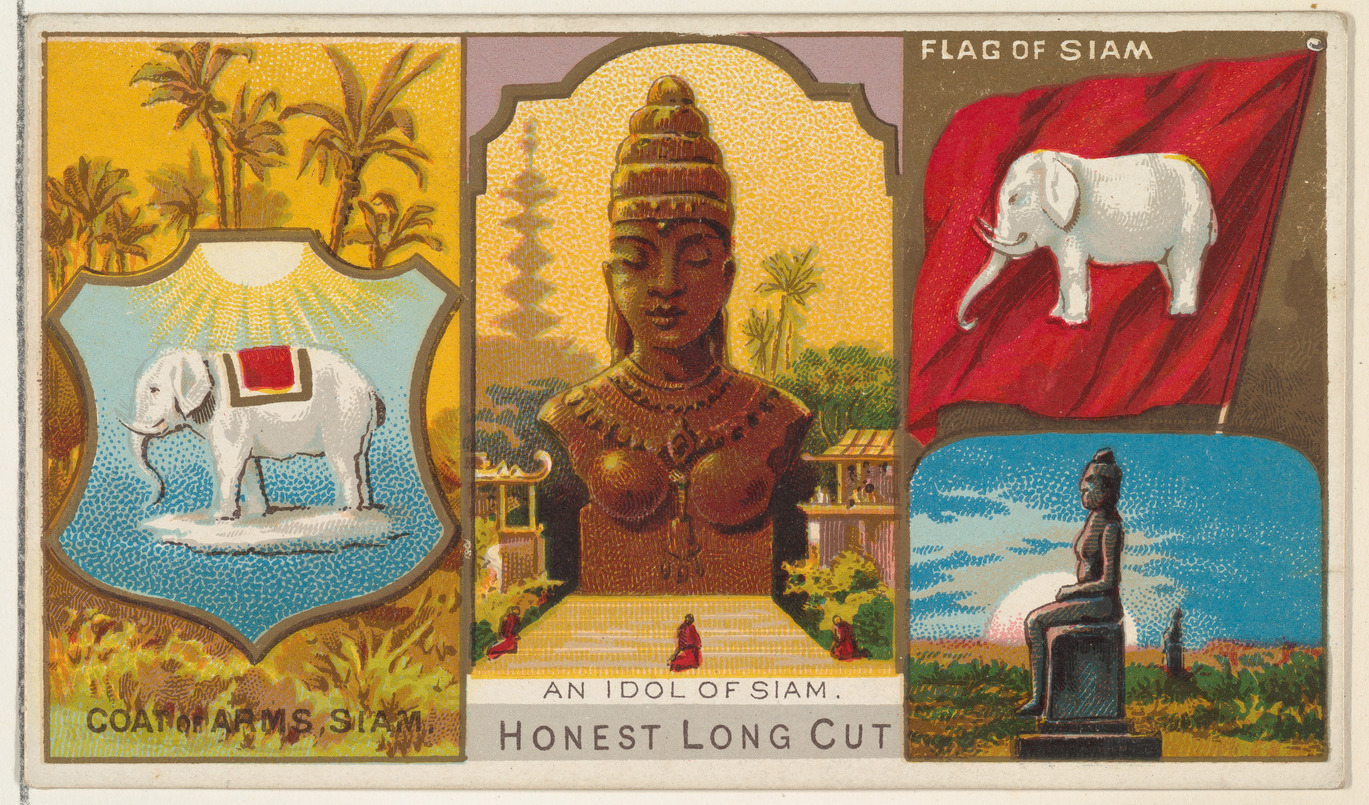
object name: print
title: An Idol of Siam, from the Rulers, Flags, and Coats of Arms series (N126-1) issued by W. Duke, Sons & Co.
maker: w. duke, sons & co.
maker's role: publisher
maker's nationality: american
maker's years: 1870-1920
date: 1888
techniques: color lithograph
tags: elephants